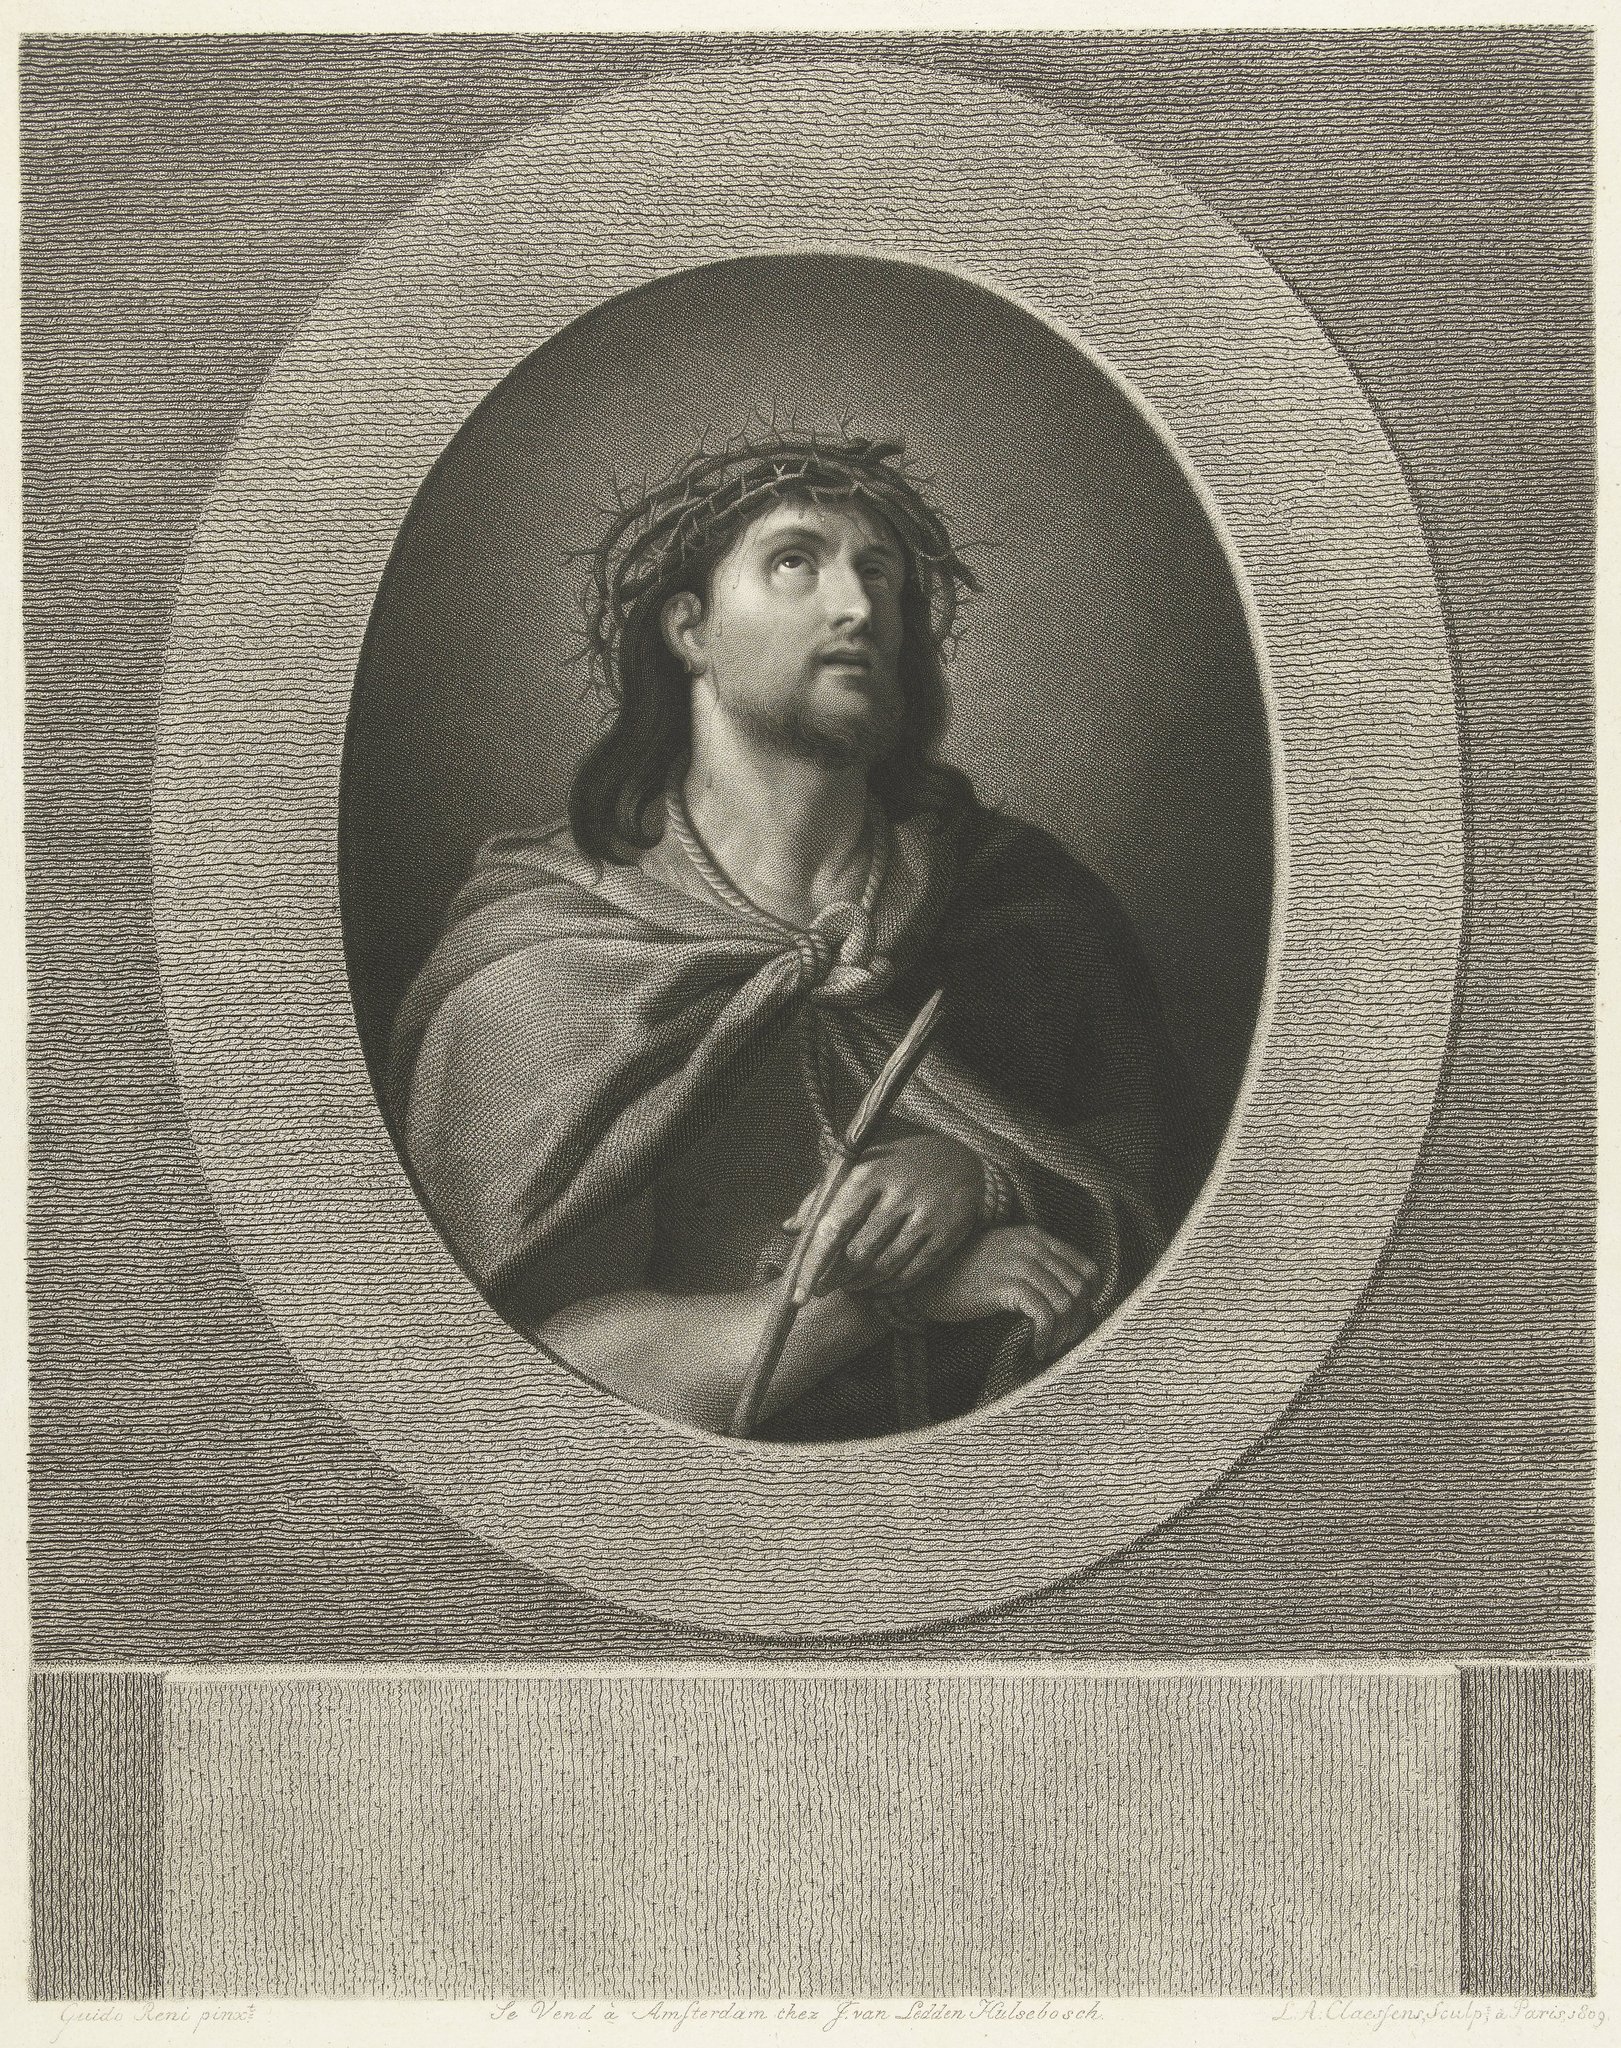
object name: print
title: Christus geboeid en met doornenkroon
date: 1809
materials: paper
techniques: engraving, etching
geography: paris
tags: christ triumphing (with crown, head usually upright)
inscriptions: collector's mark: Lugt 2228